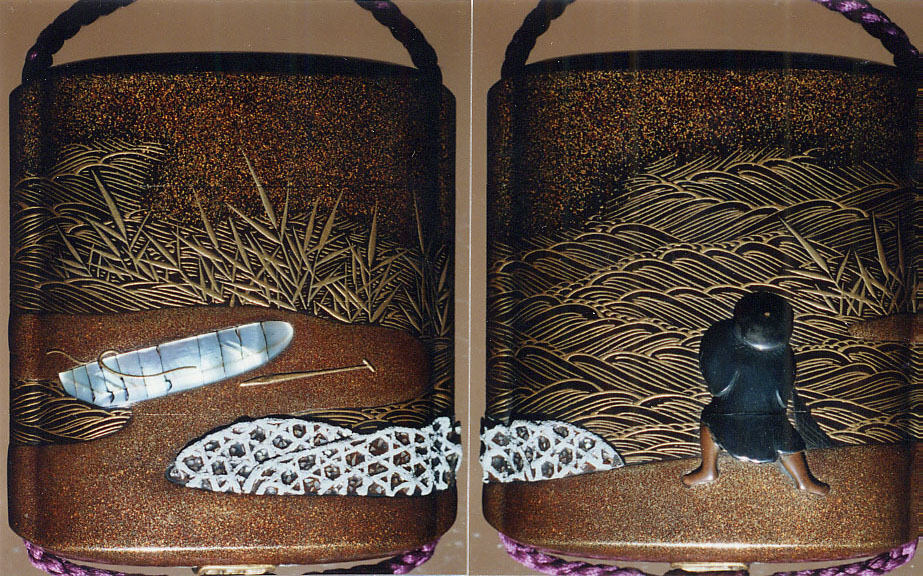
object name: inrō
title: Case (Inrō) with Design of Fisherman, Boat, Reeds, and Stone Basket Breakwaters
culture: japanese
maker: tsuchiya yasuchika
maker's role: artist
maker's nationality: japanese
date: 1801-1900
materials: gold, lacquer, metal, mother of pearl, pewter, wood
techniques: carving, enamel, inlay, maki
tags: men,boats